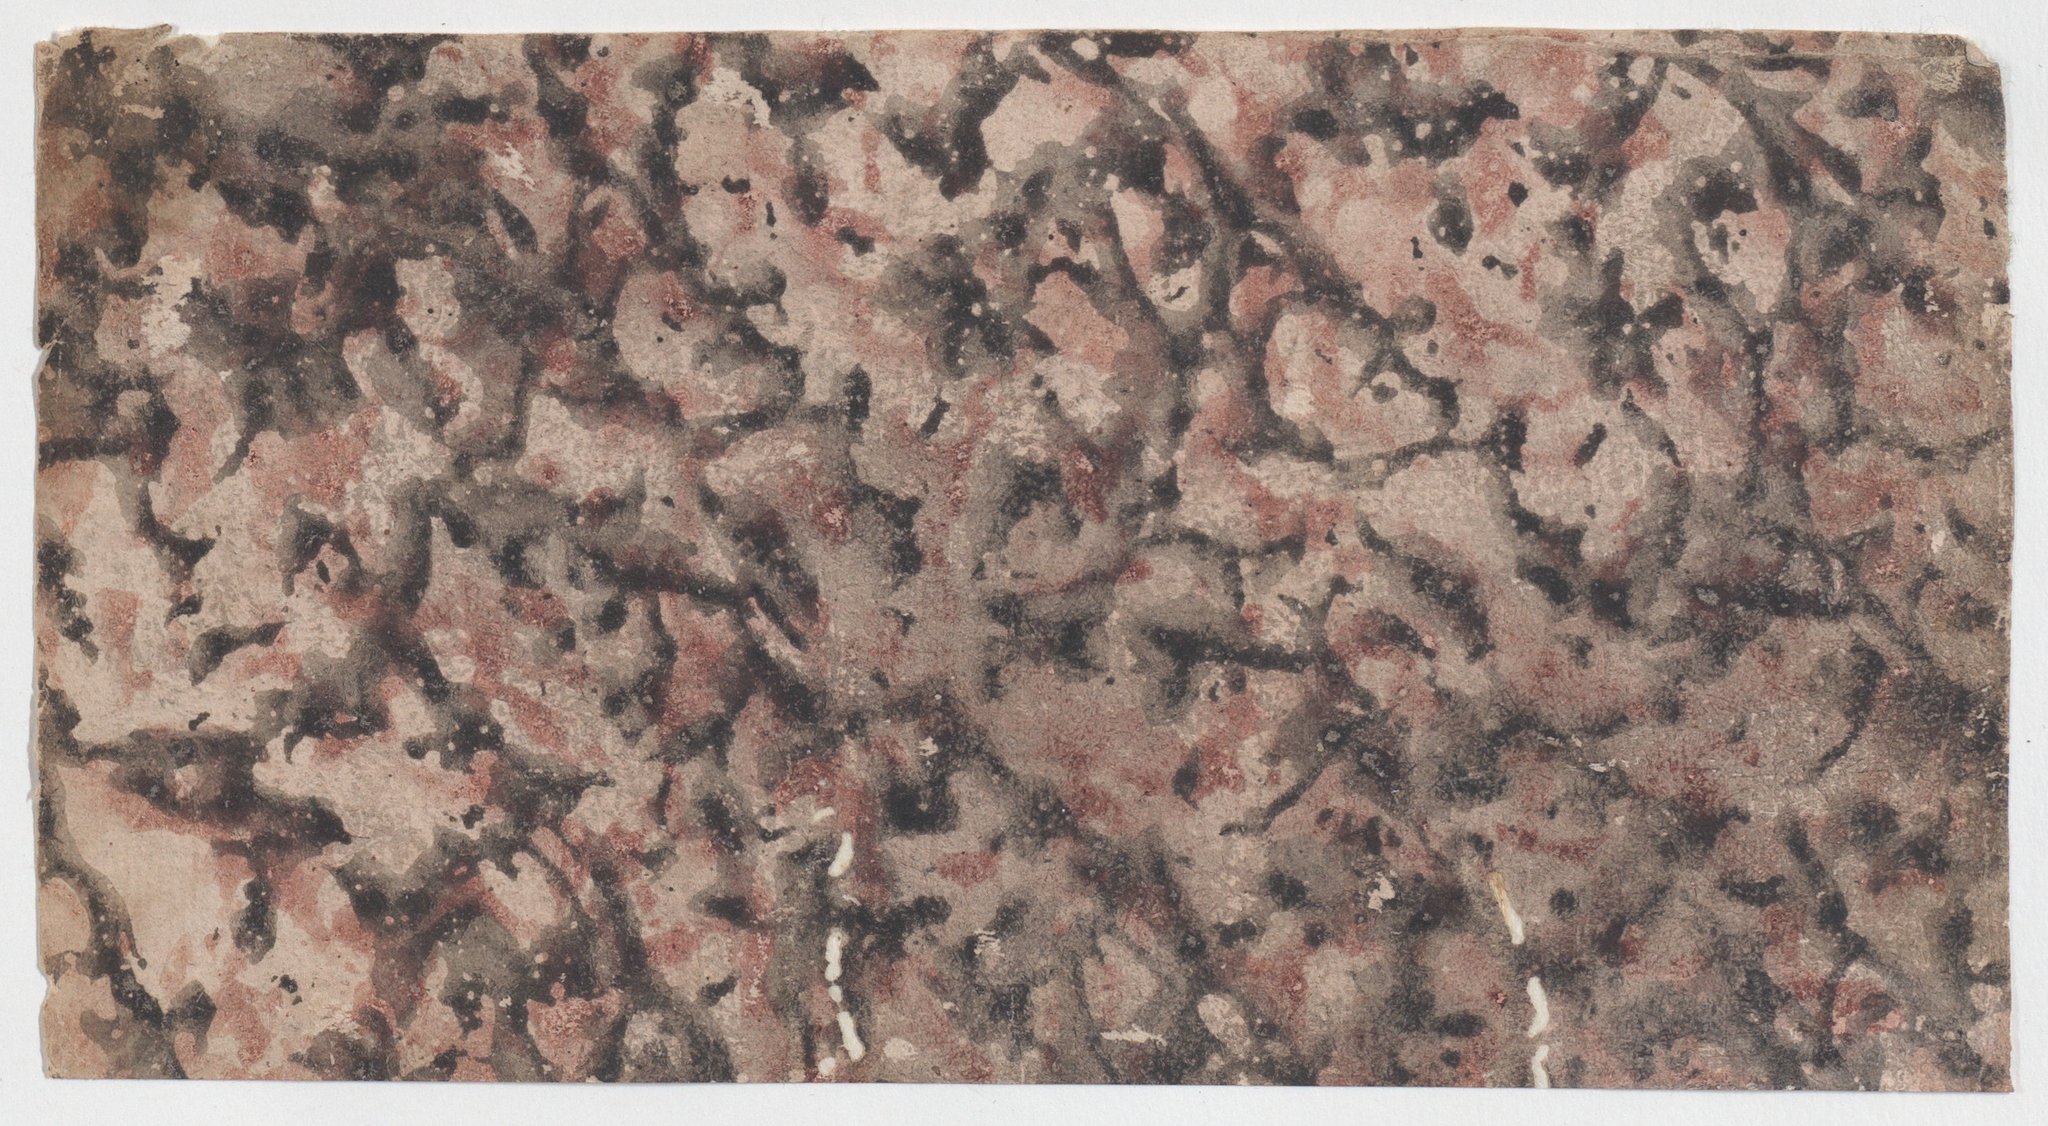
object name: print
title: Sheet with overall splotchy pattern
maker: Anonymous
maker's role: artist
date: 1801-1900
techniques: relief print